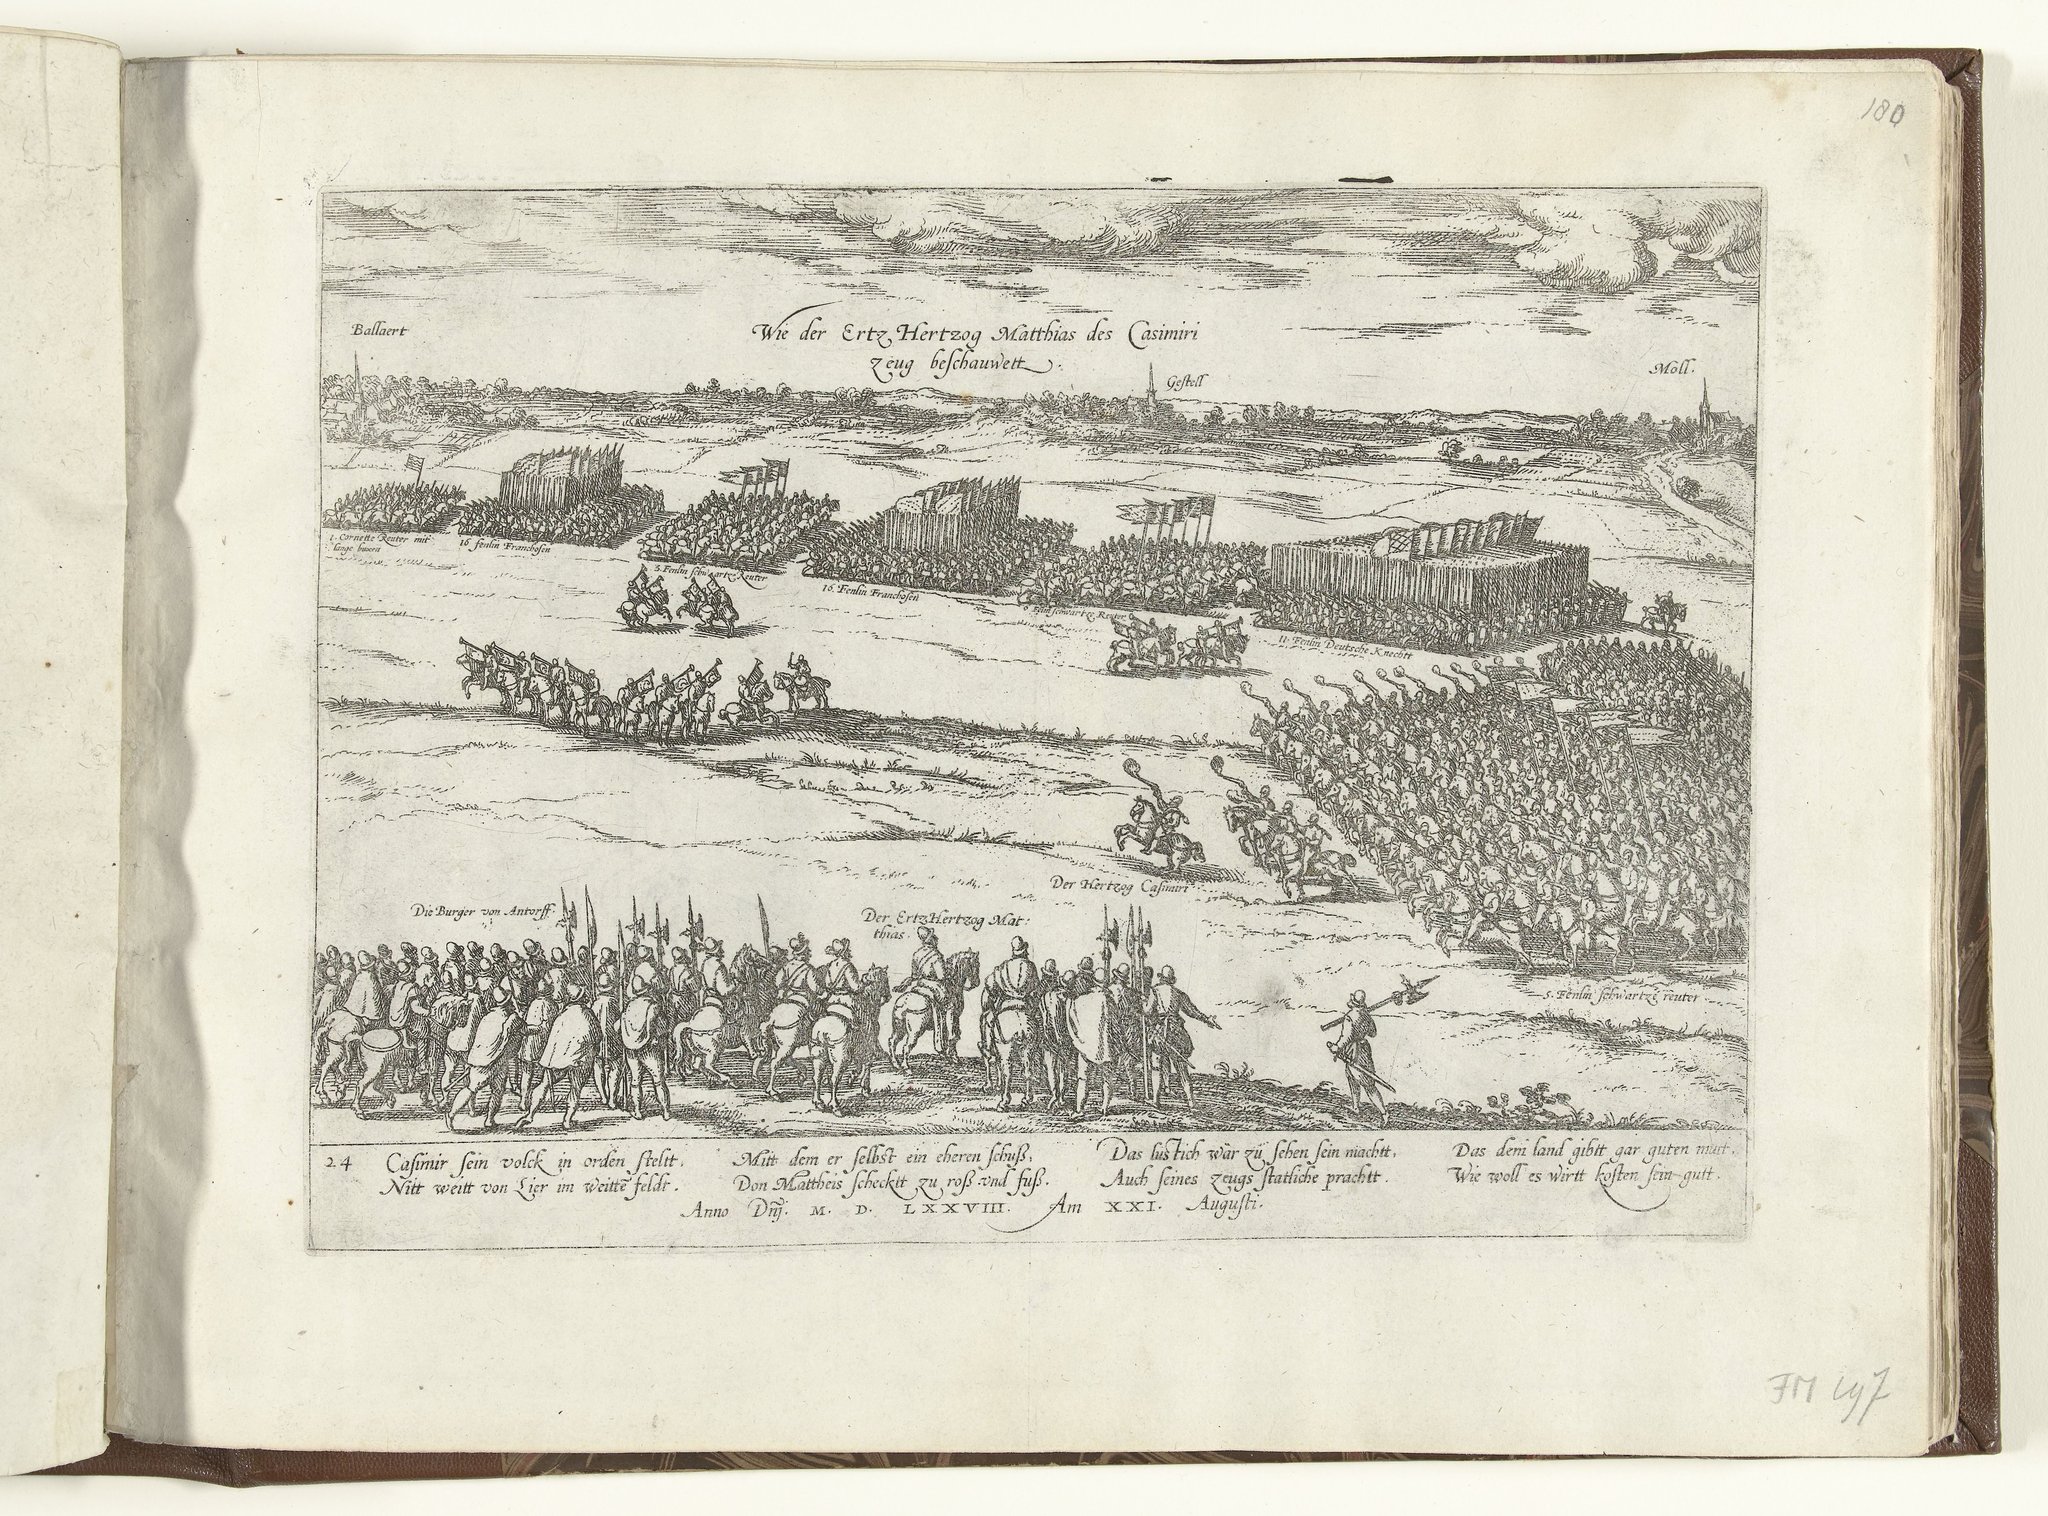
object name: print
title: Wie der Ertz Hertzog Matthias des Casimiri zeug beschauwett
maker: frans hogenberg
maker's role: print maker, publisher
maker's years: 1538-1590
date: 1578-1580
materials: paper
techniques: etching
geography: cologne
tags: matthias van oostenrijk (rooms-duits keizer), review, inspection (of company, unit, troop), lierre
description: Aartshertog Matthias houdt revue over de troepen van paltsgraaf Casimir, 21 augustus 1578, bij Lier. Op de achtergrond de dorpen Ballaert, Gestel en Mol. Met onderschrift van 8 regels in het Duits. Genummerd: 24.